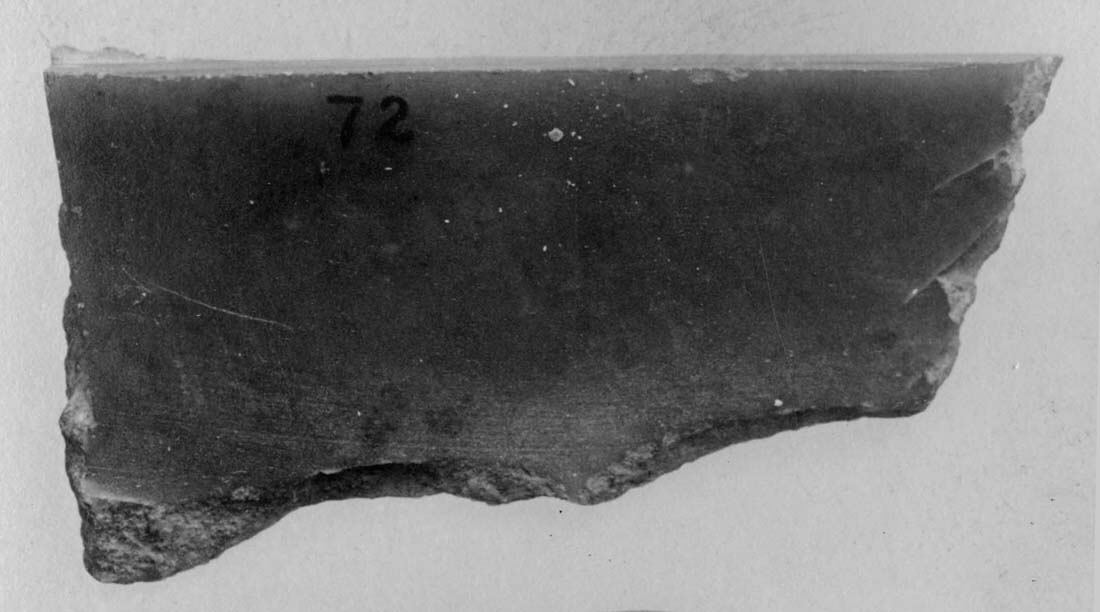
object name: fragment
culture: chinese or turkestani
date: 1902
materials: jade